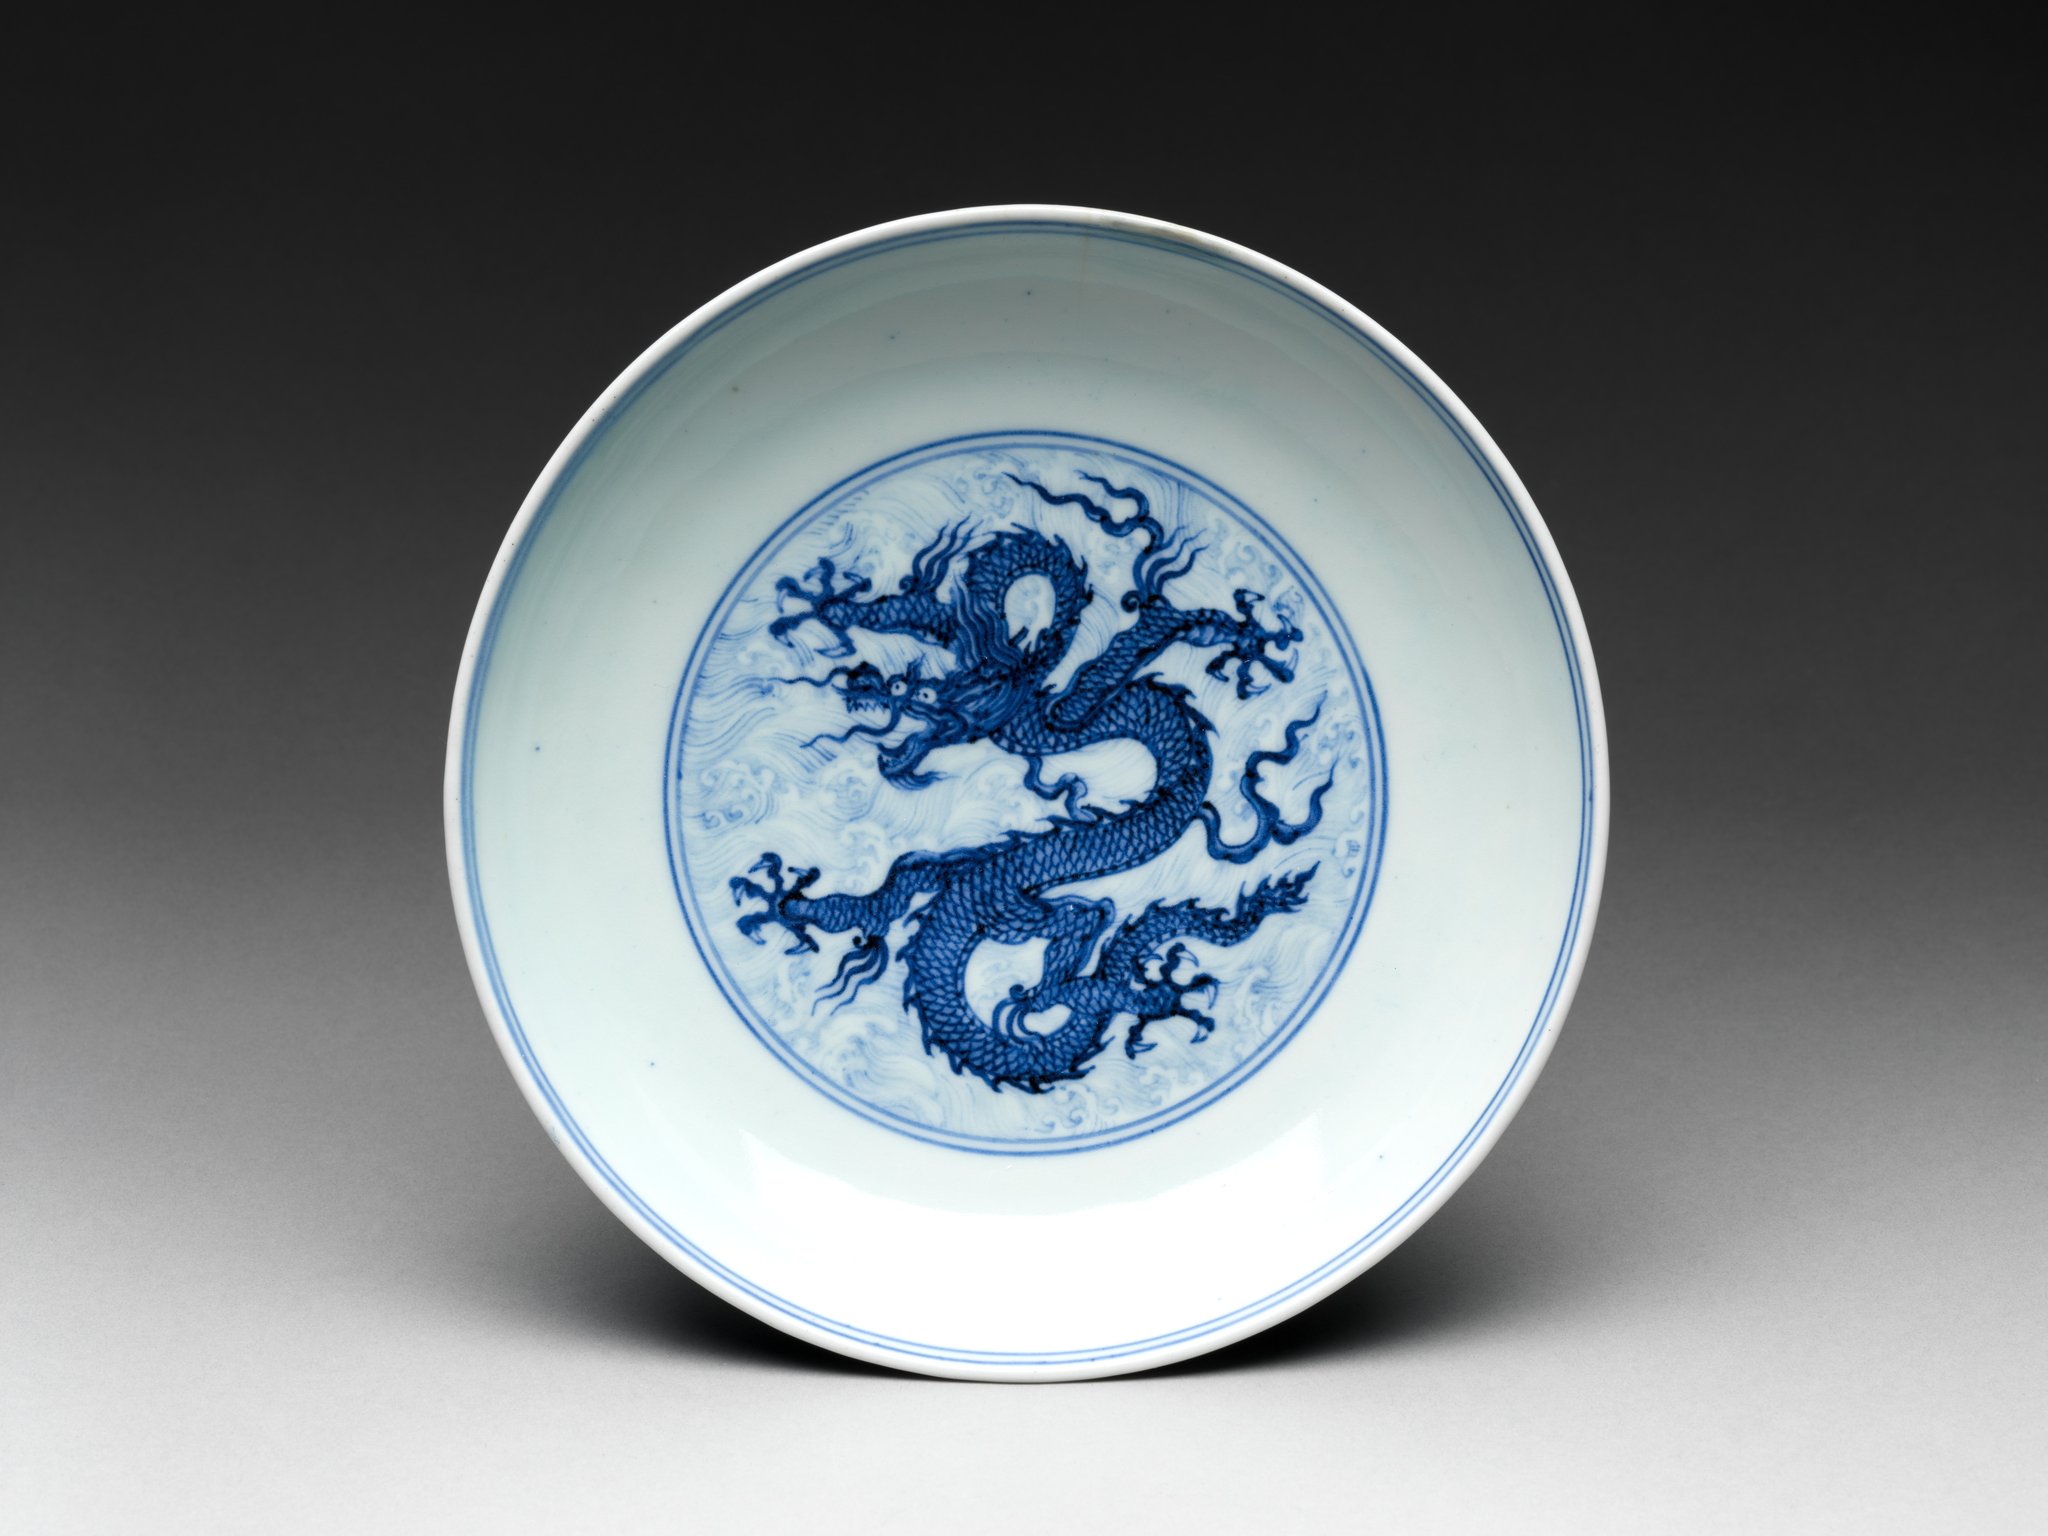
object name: dish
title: Dish with dragon amid waves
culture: chinese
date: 1426-1435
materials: cobalt, glaze, porcelain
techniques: painting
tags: dragons